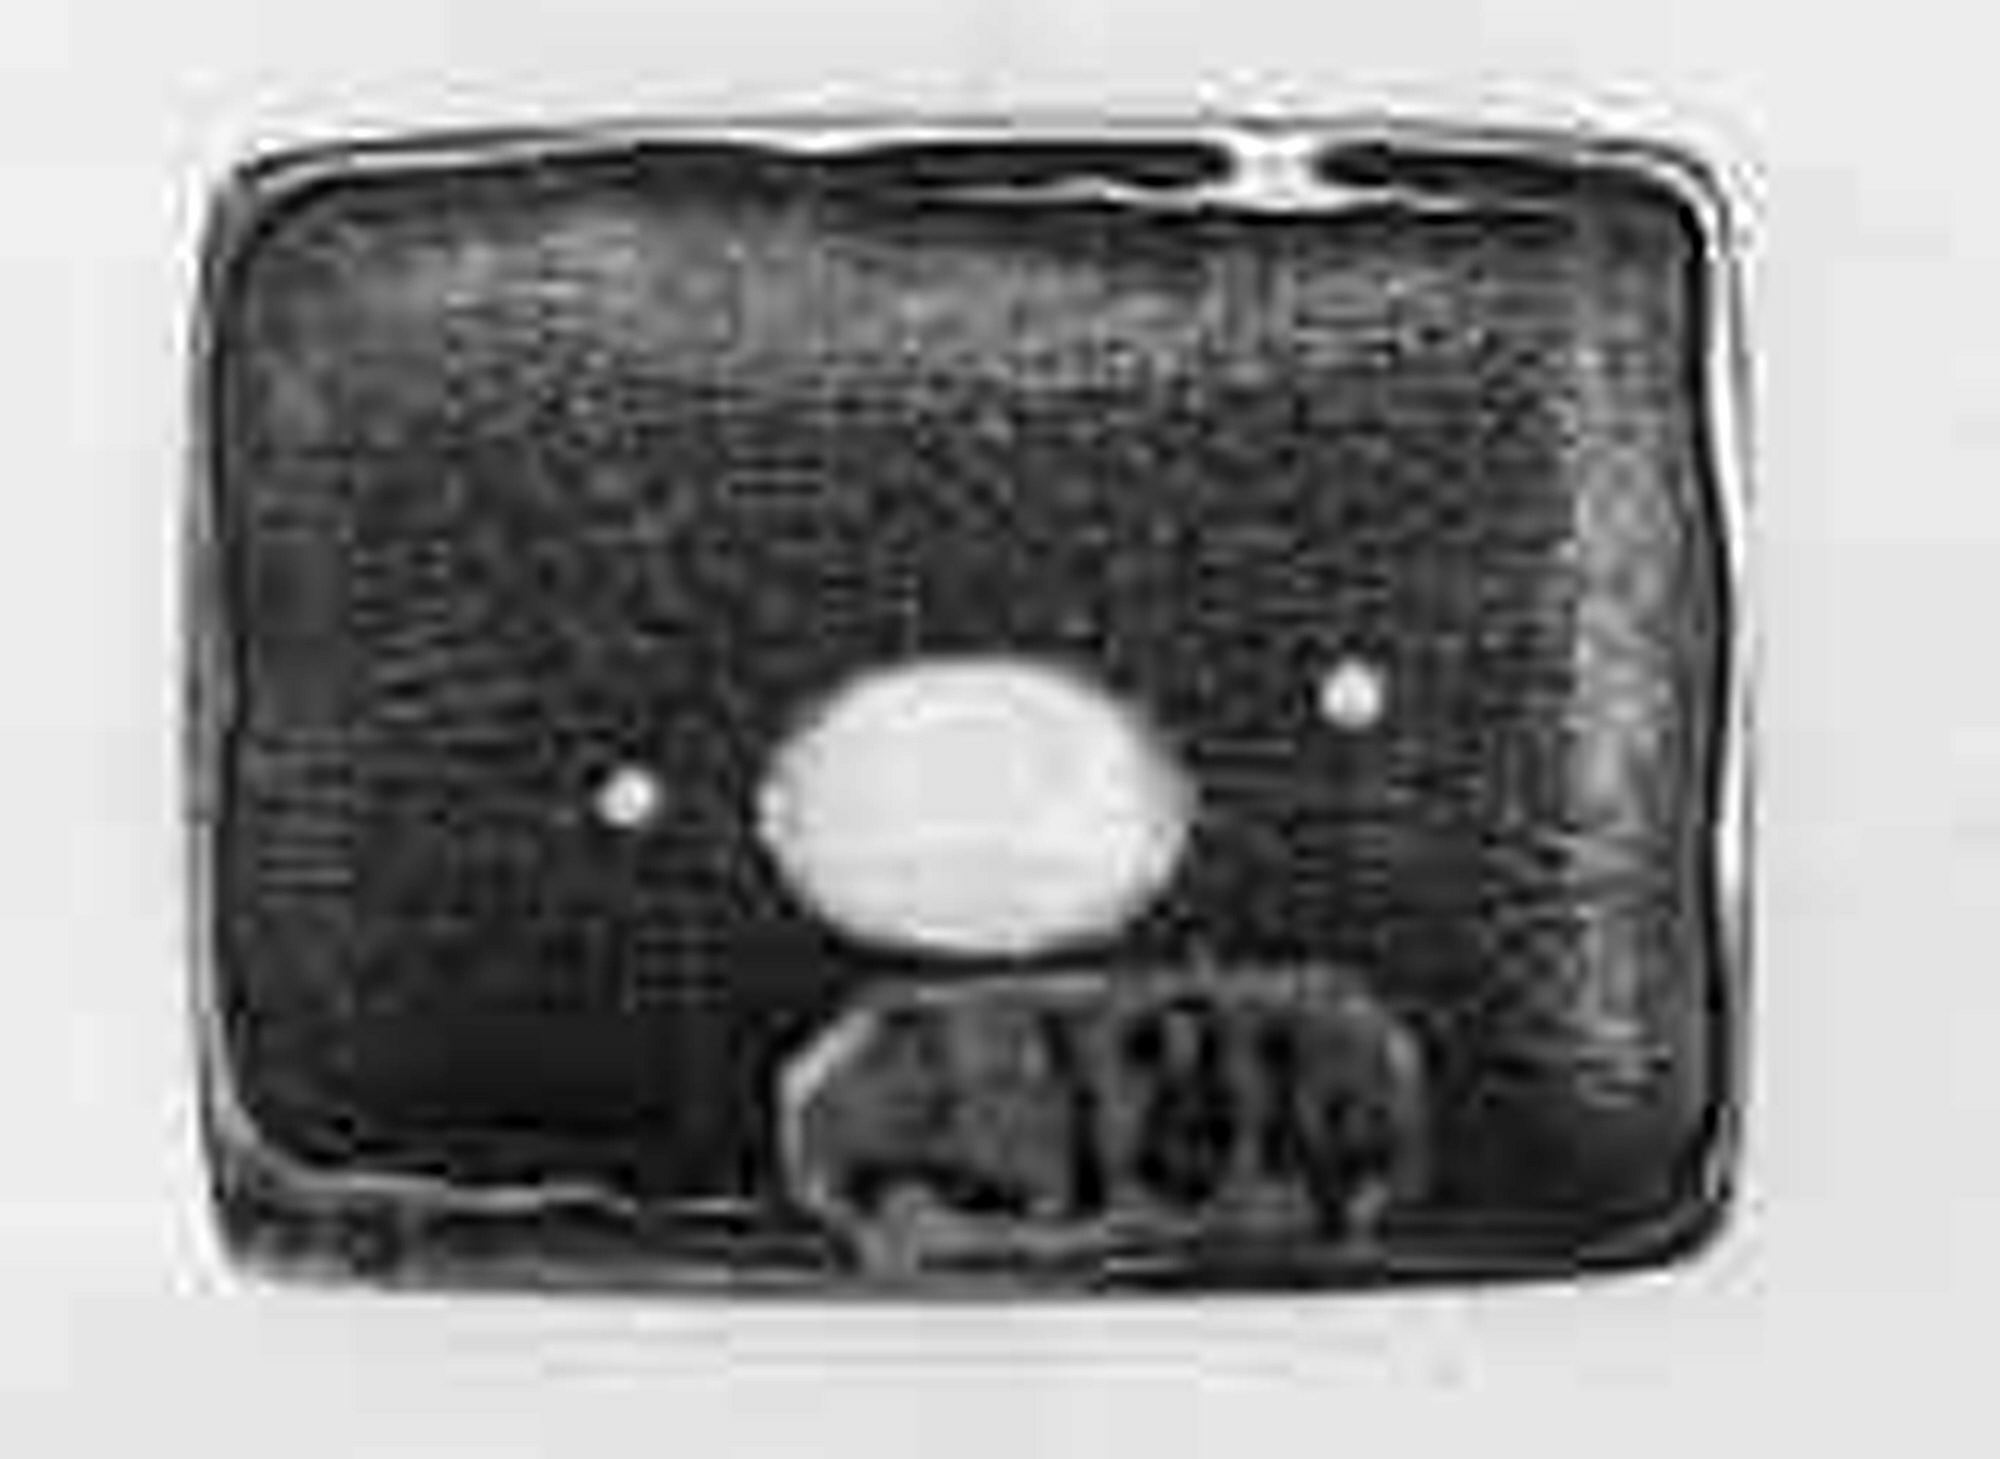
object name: clasp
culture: japanese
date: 1801-1900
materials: gold